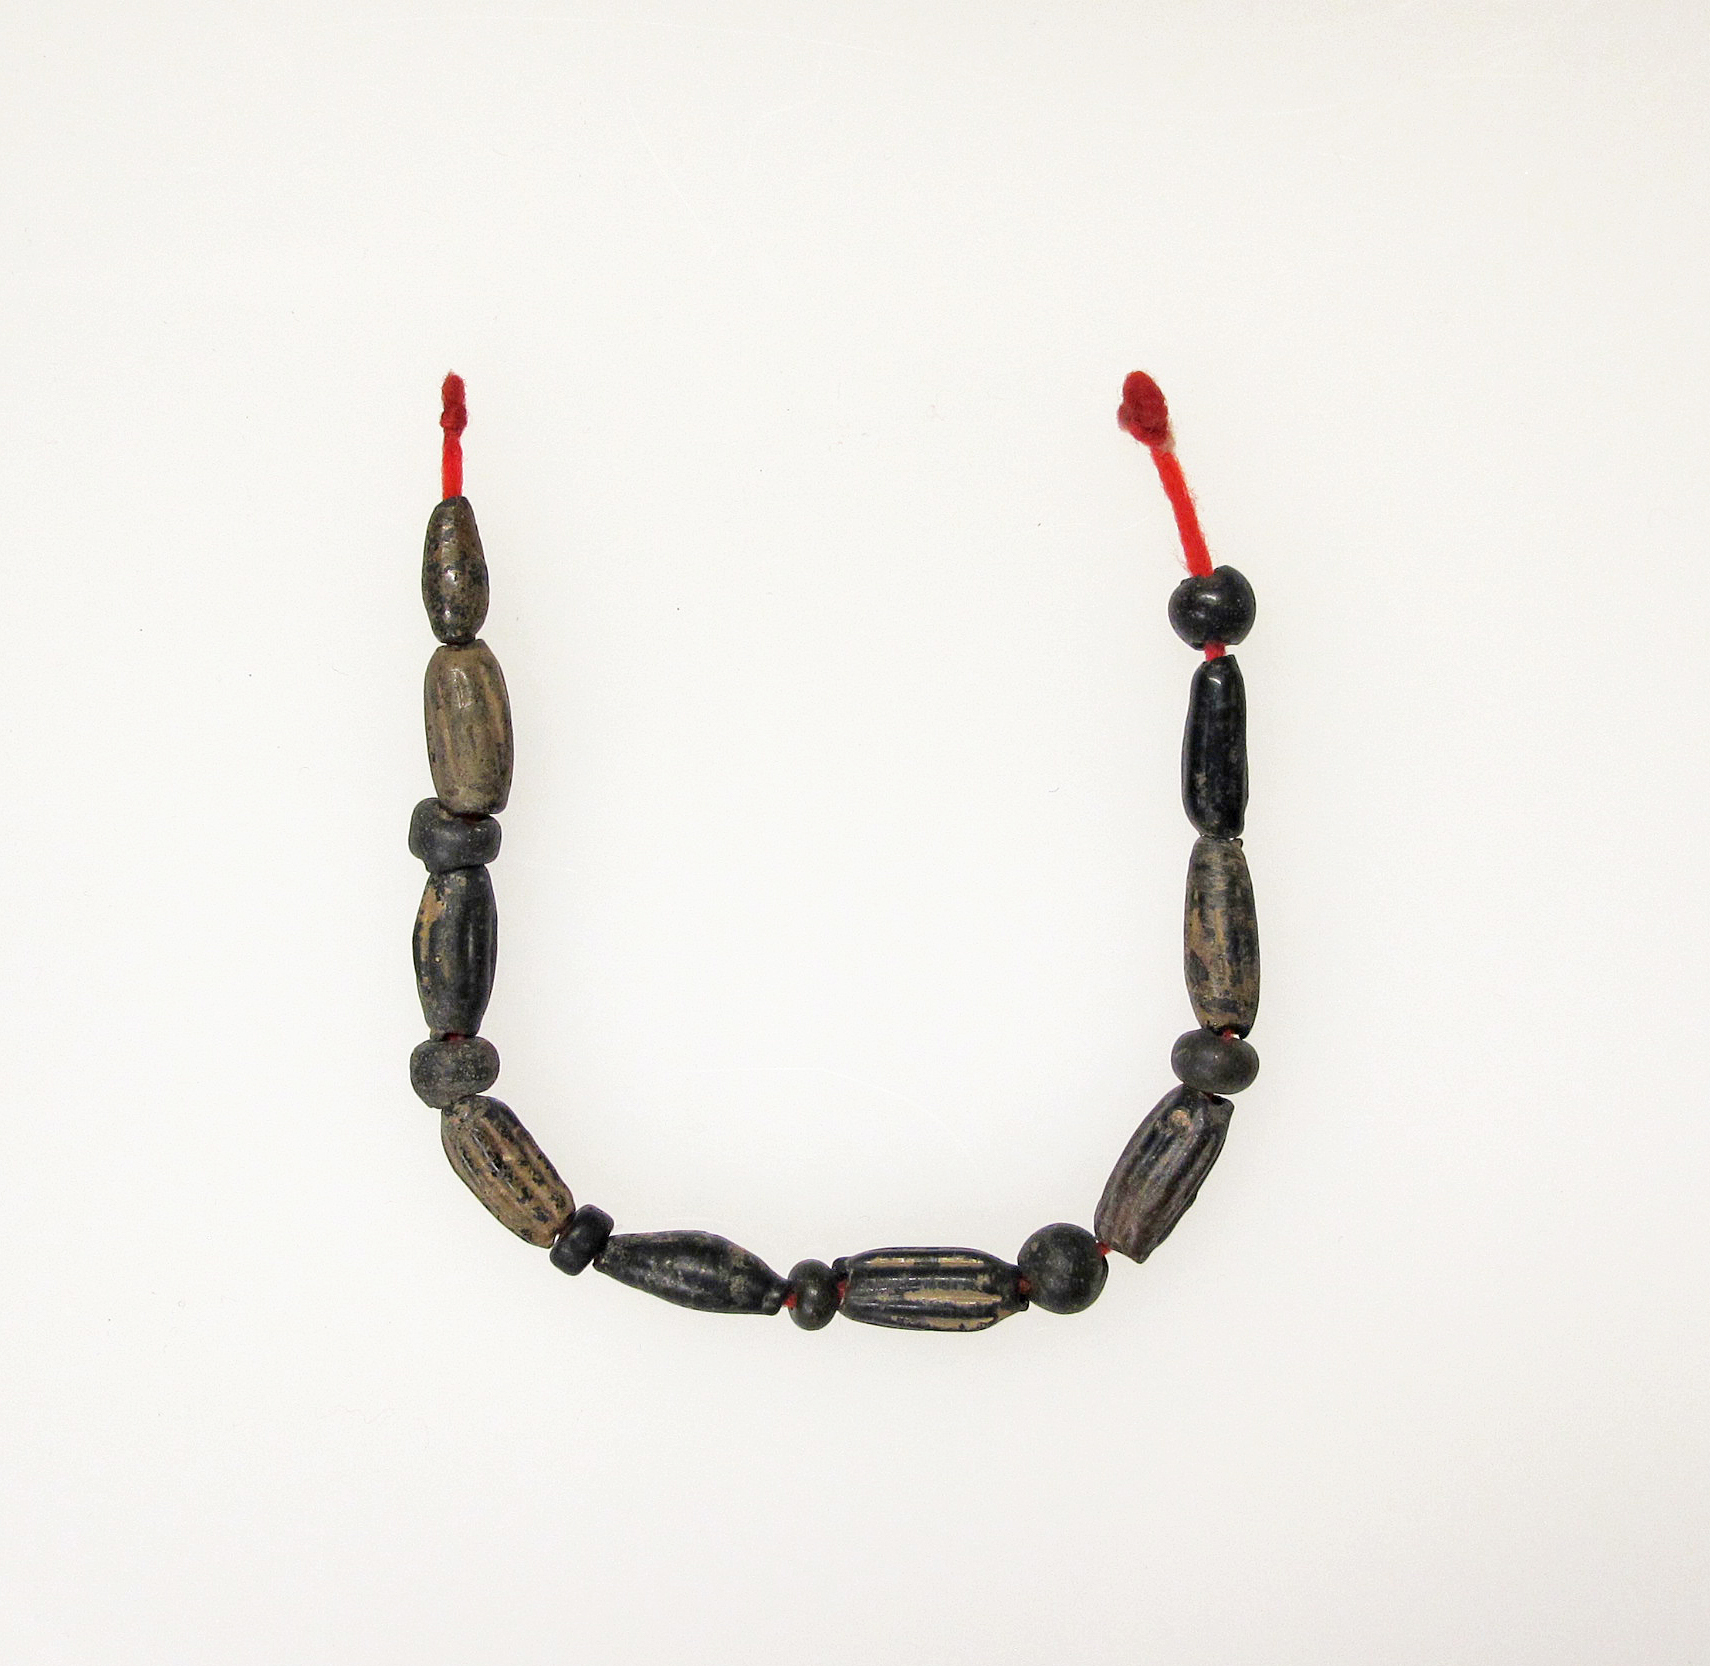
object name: necklace with 16 bead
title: Necklace with 16 beads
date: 7000 BCE-330 CE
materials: glass